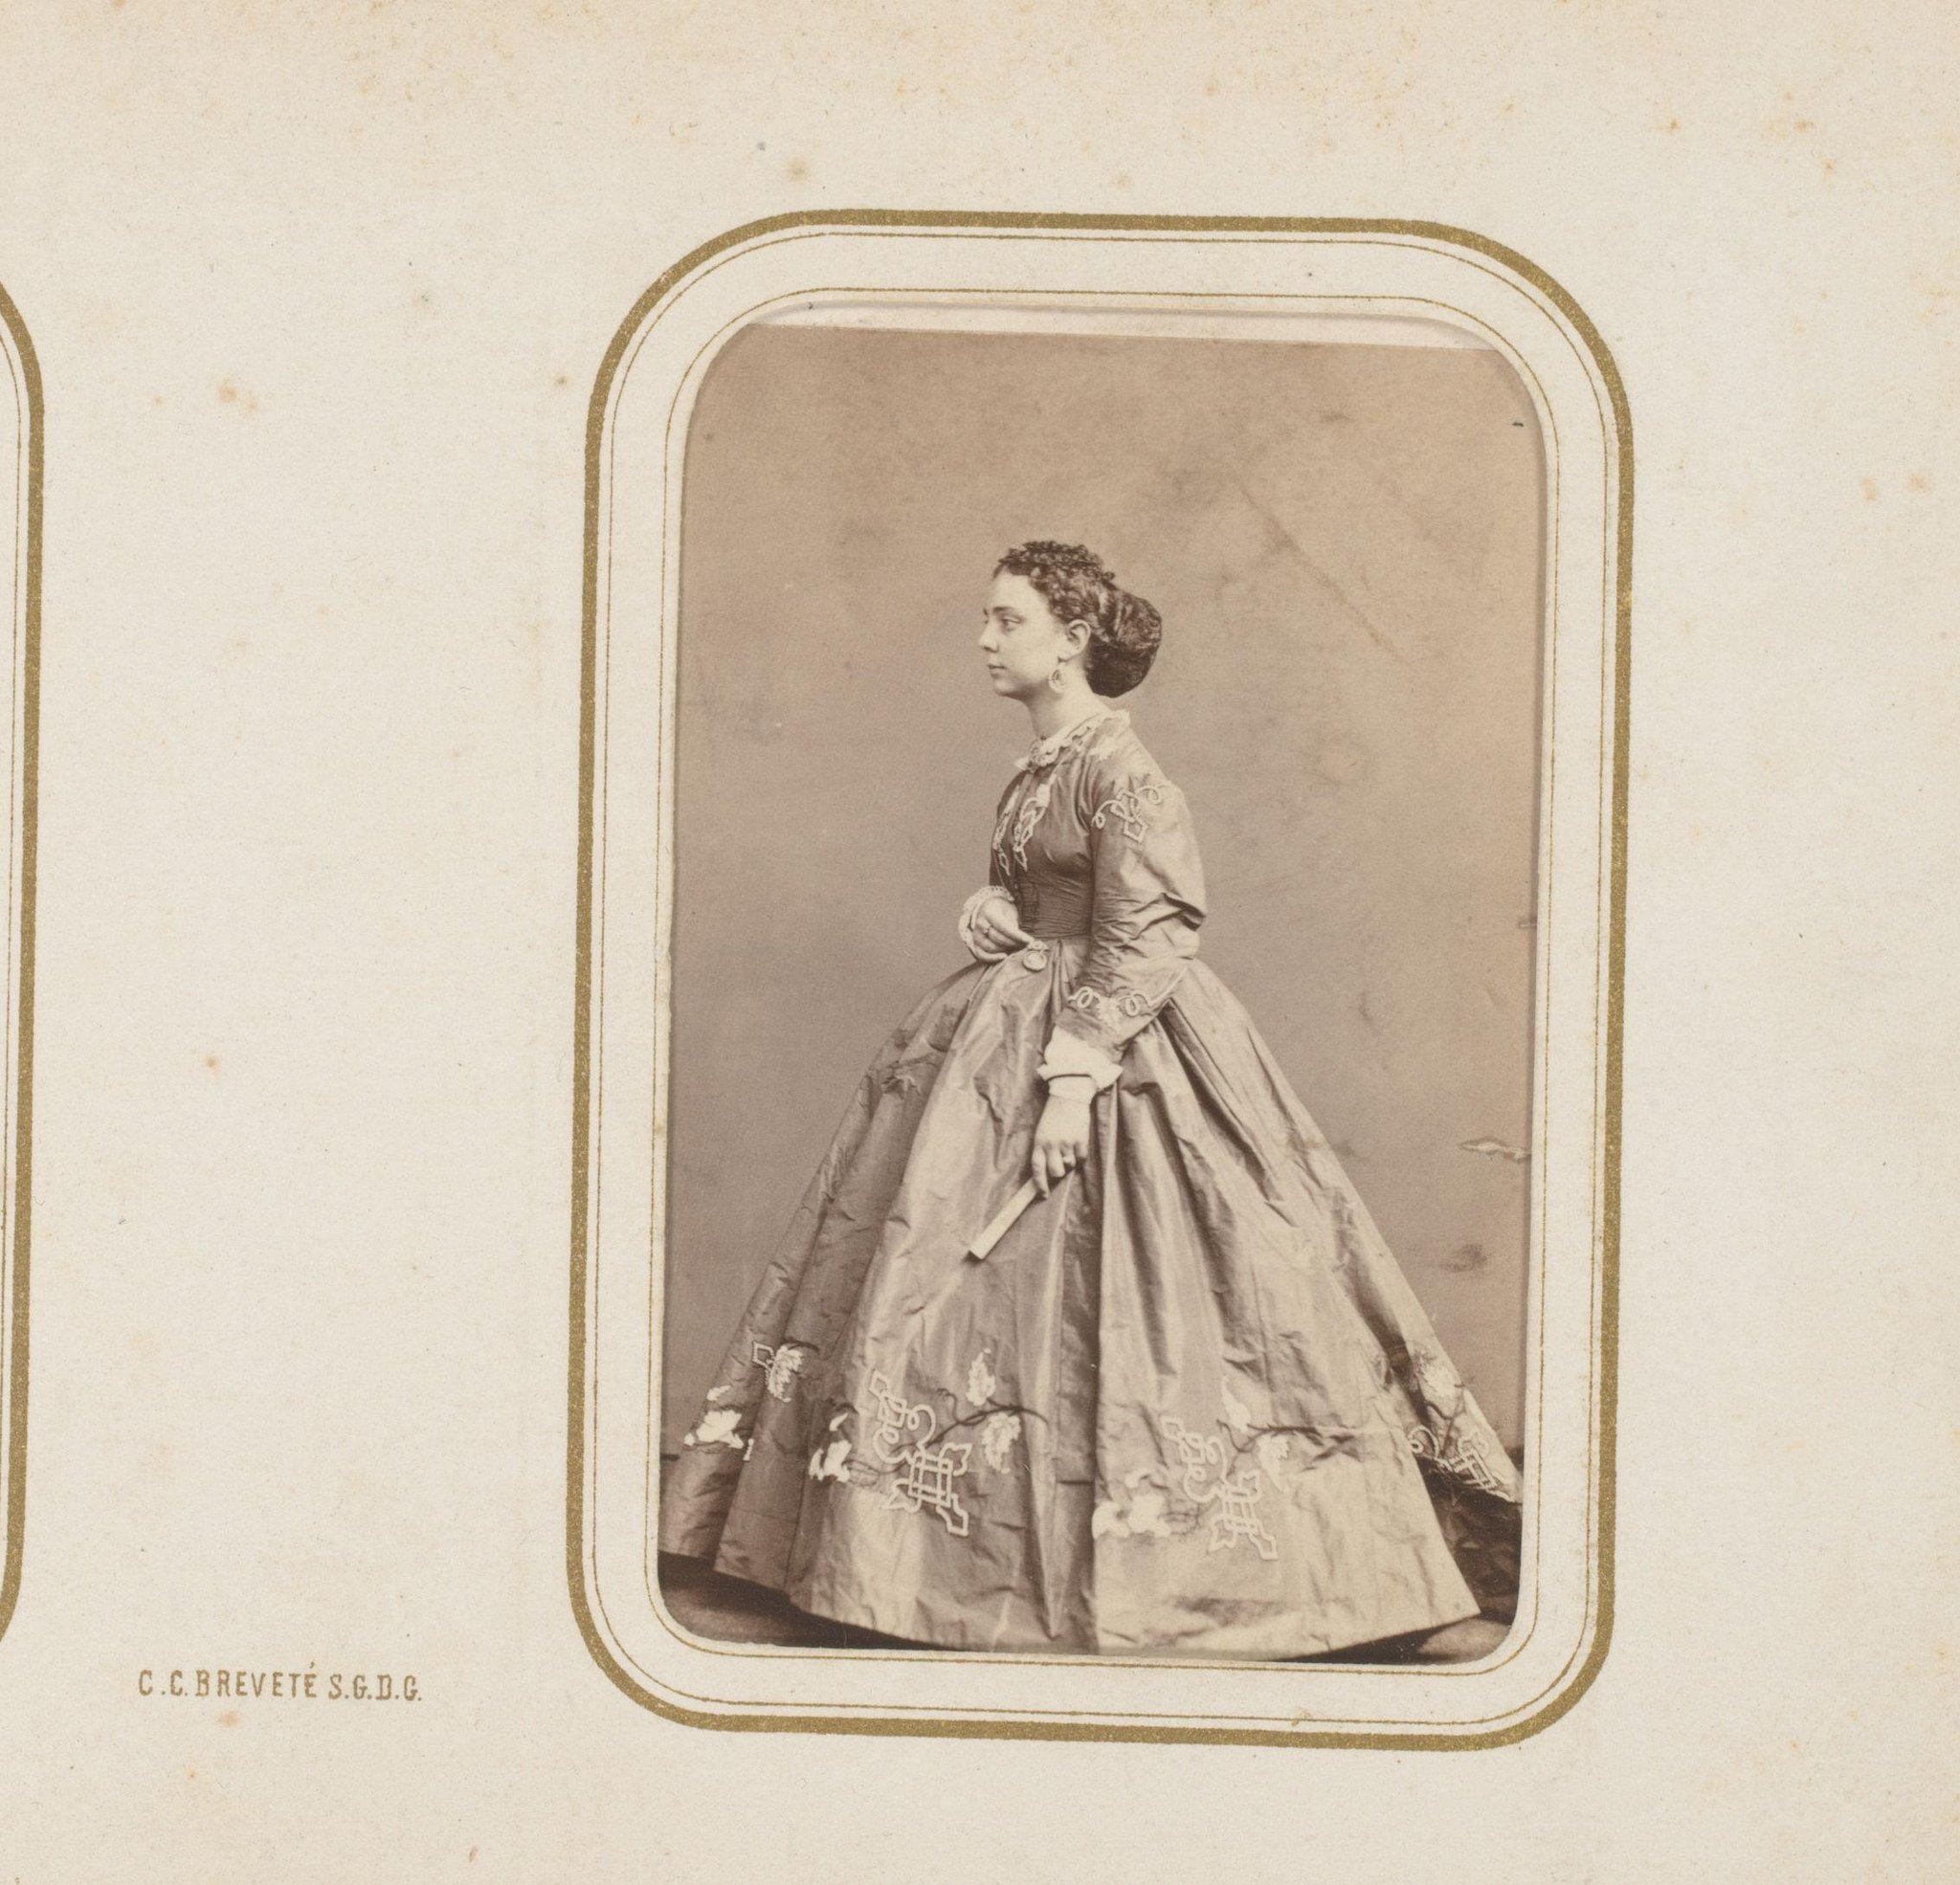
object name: photograph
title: Portret van een jonge vrouw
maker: Anonymous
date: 1860-1900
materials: cardboard, photographic support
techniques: albumen print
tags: adolescent, young woman, maiden, the (nude) human figure; 'corpo humano' (ripa) (+ sideview, profile), historical persons